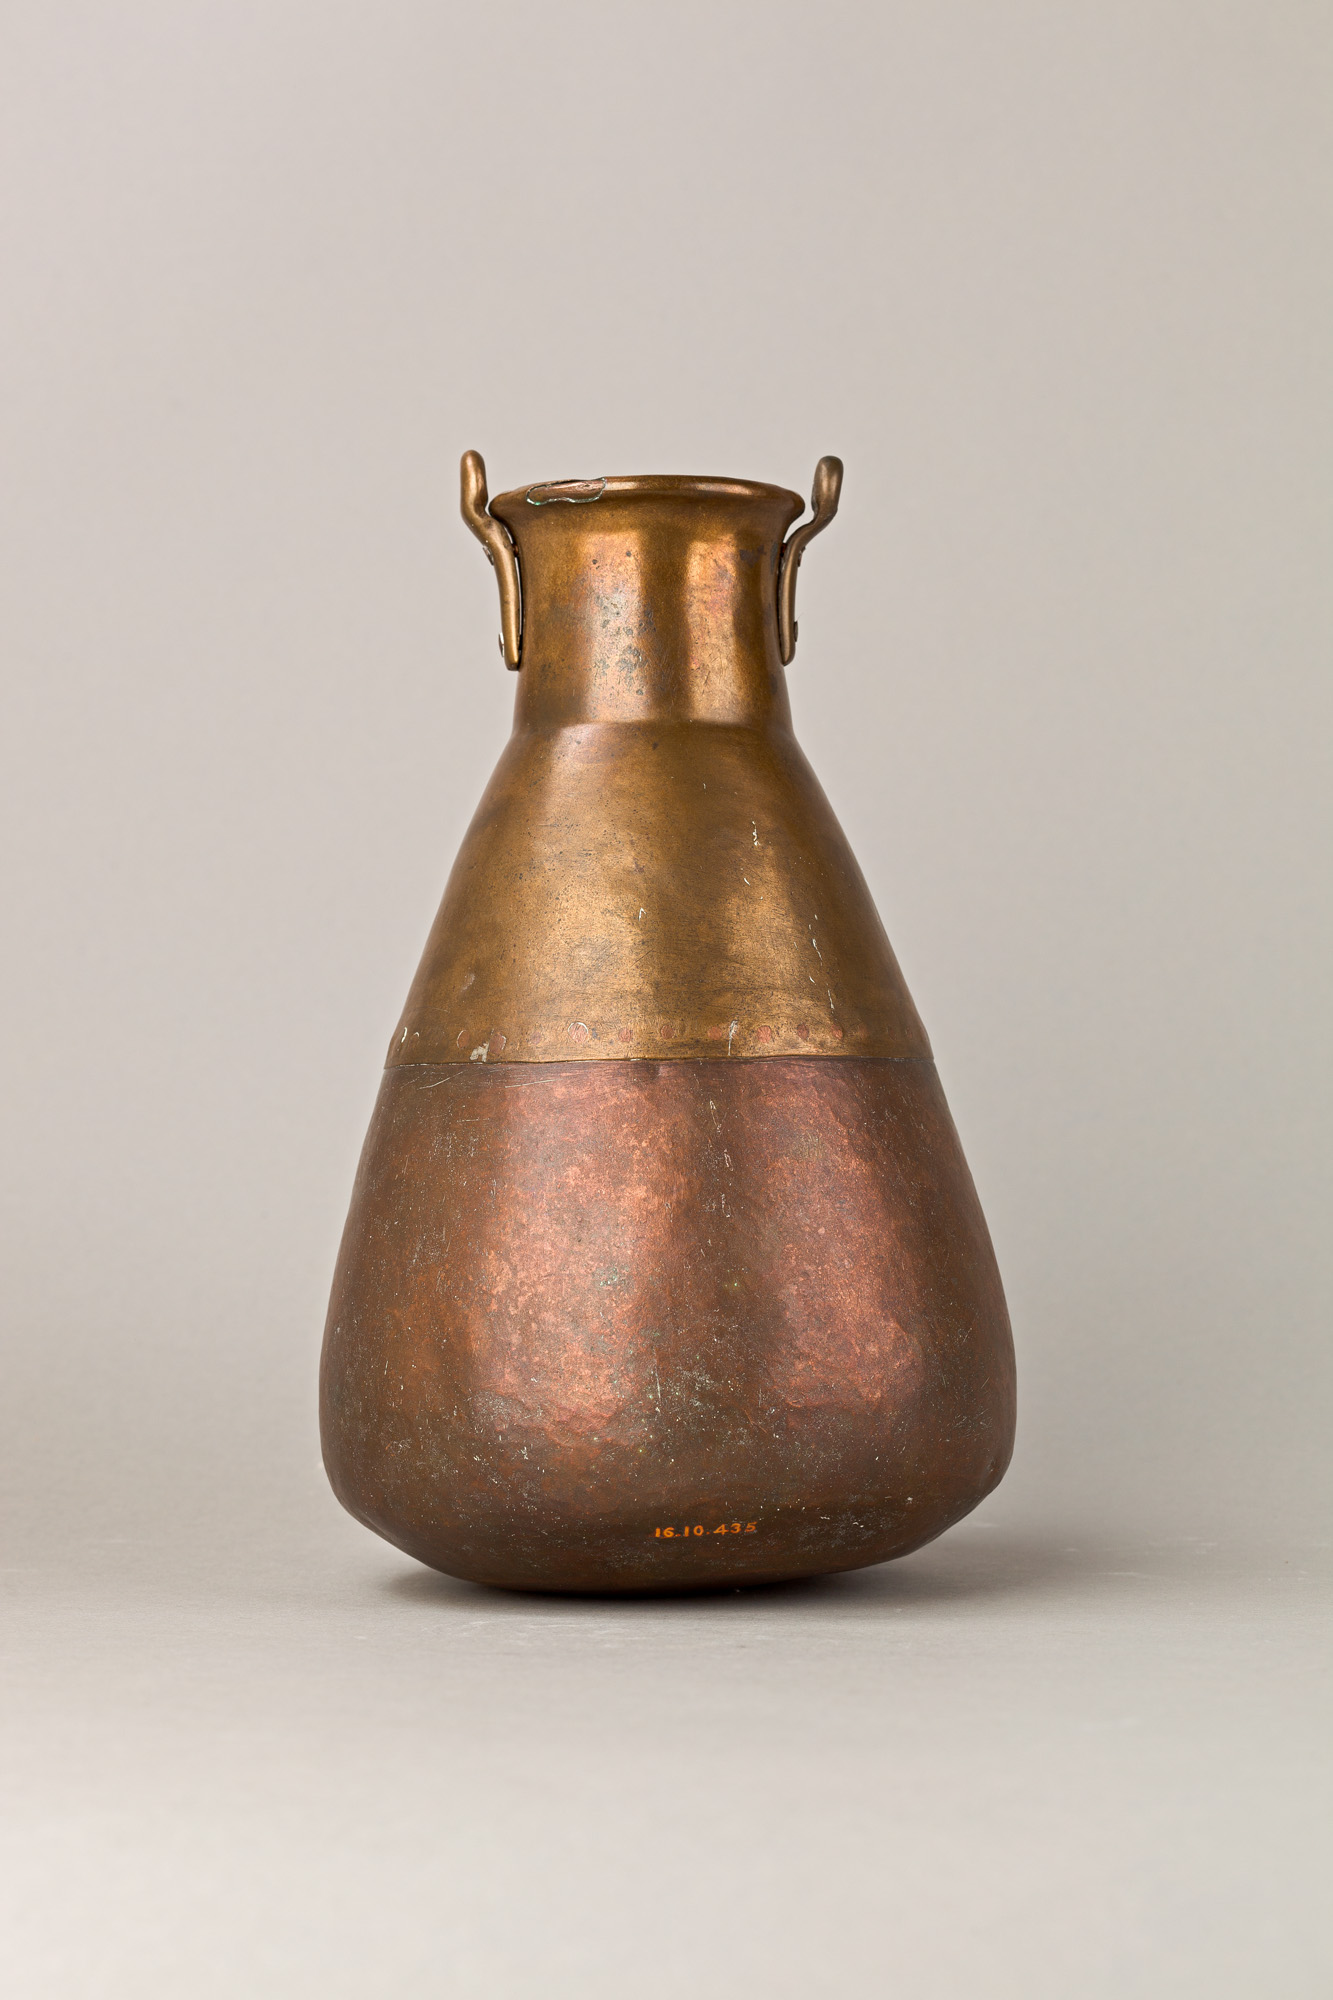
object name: jar, metal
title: SItula-shaped Jar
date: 1550-1458 BCE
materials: bronze, copper alloy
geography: egypt